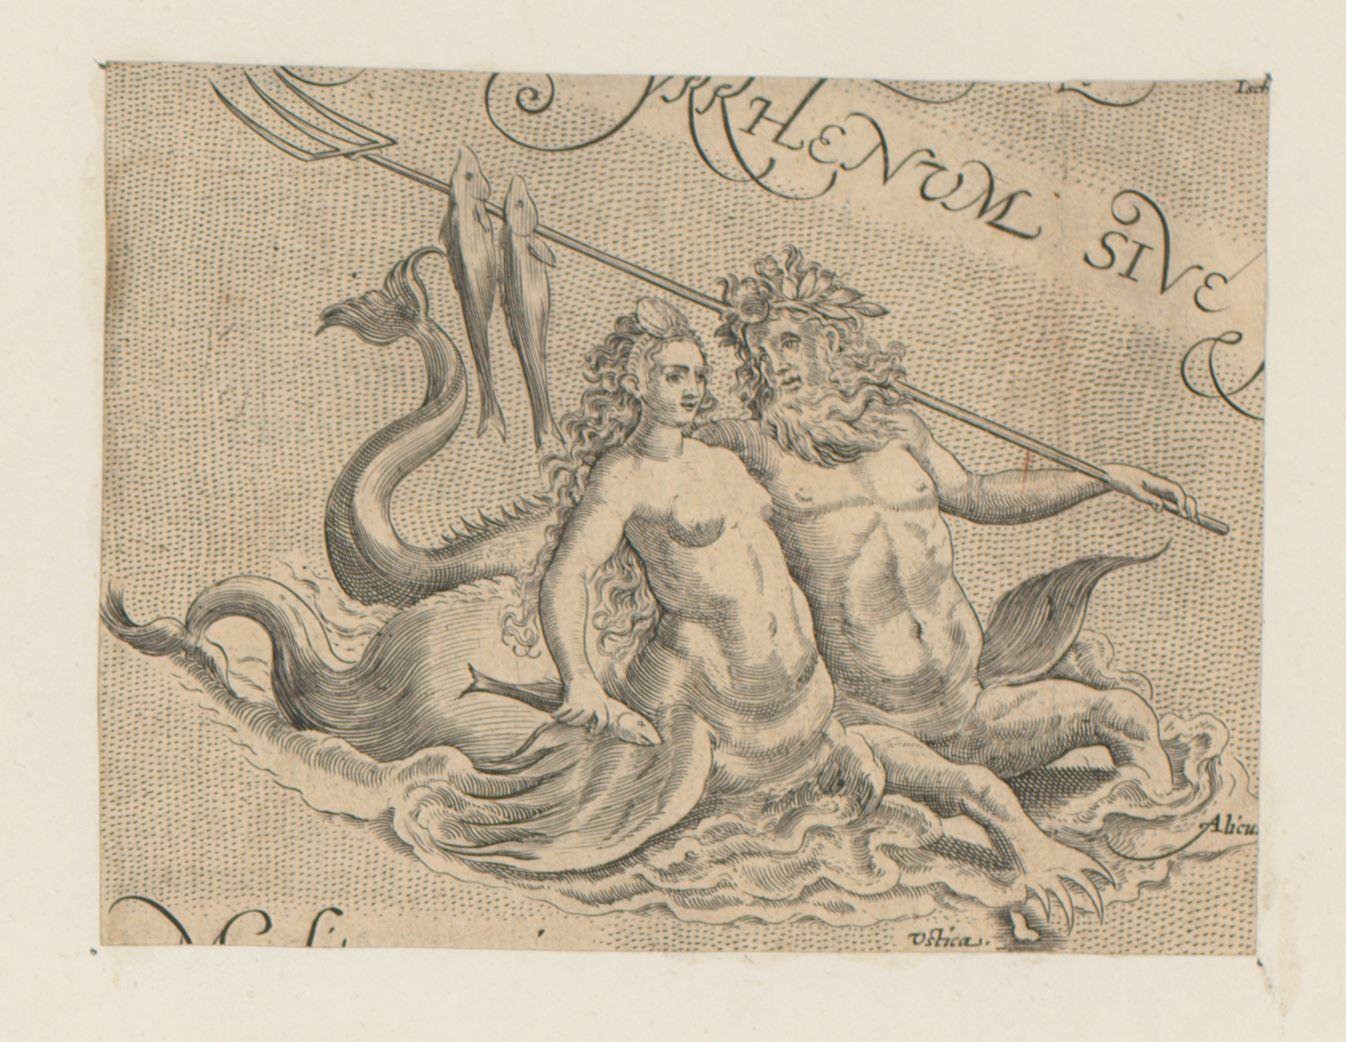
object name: album leaf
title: Theatrum Orbis Terrarum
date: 1584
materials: paper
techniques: engraving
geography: antwerp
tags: (story of) neptune (poseidon)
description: Neptunus en zijn vrouw Amphritite. Aan de drietand van Neptunus zijn twee vissen gespietst. Het ornament is een fragment van een kaart van Italië. De prent maakt deel uit van een album.